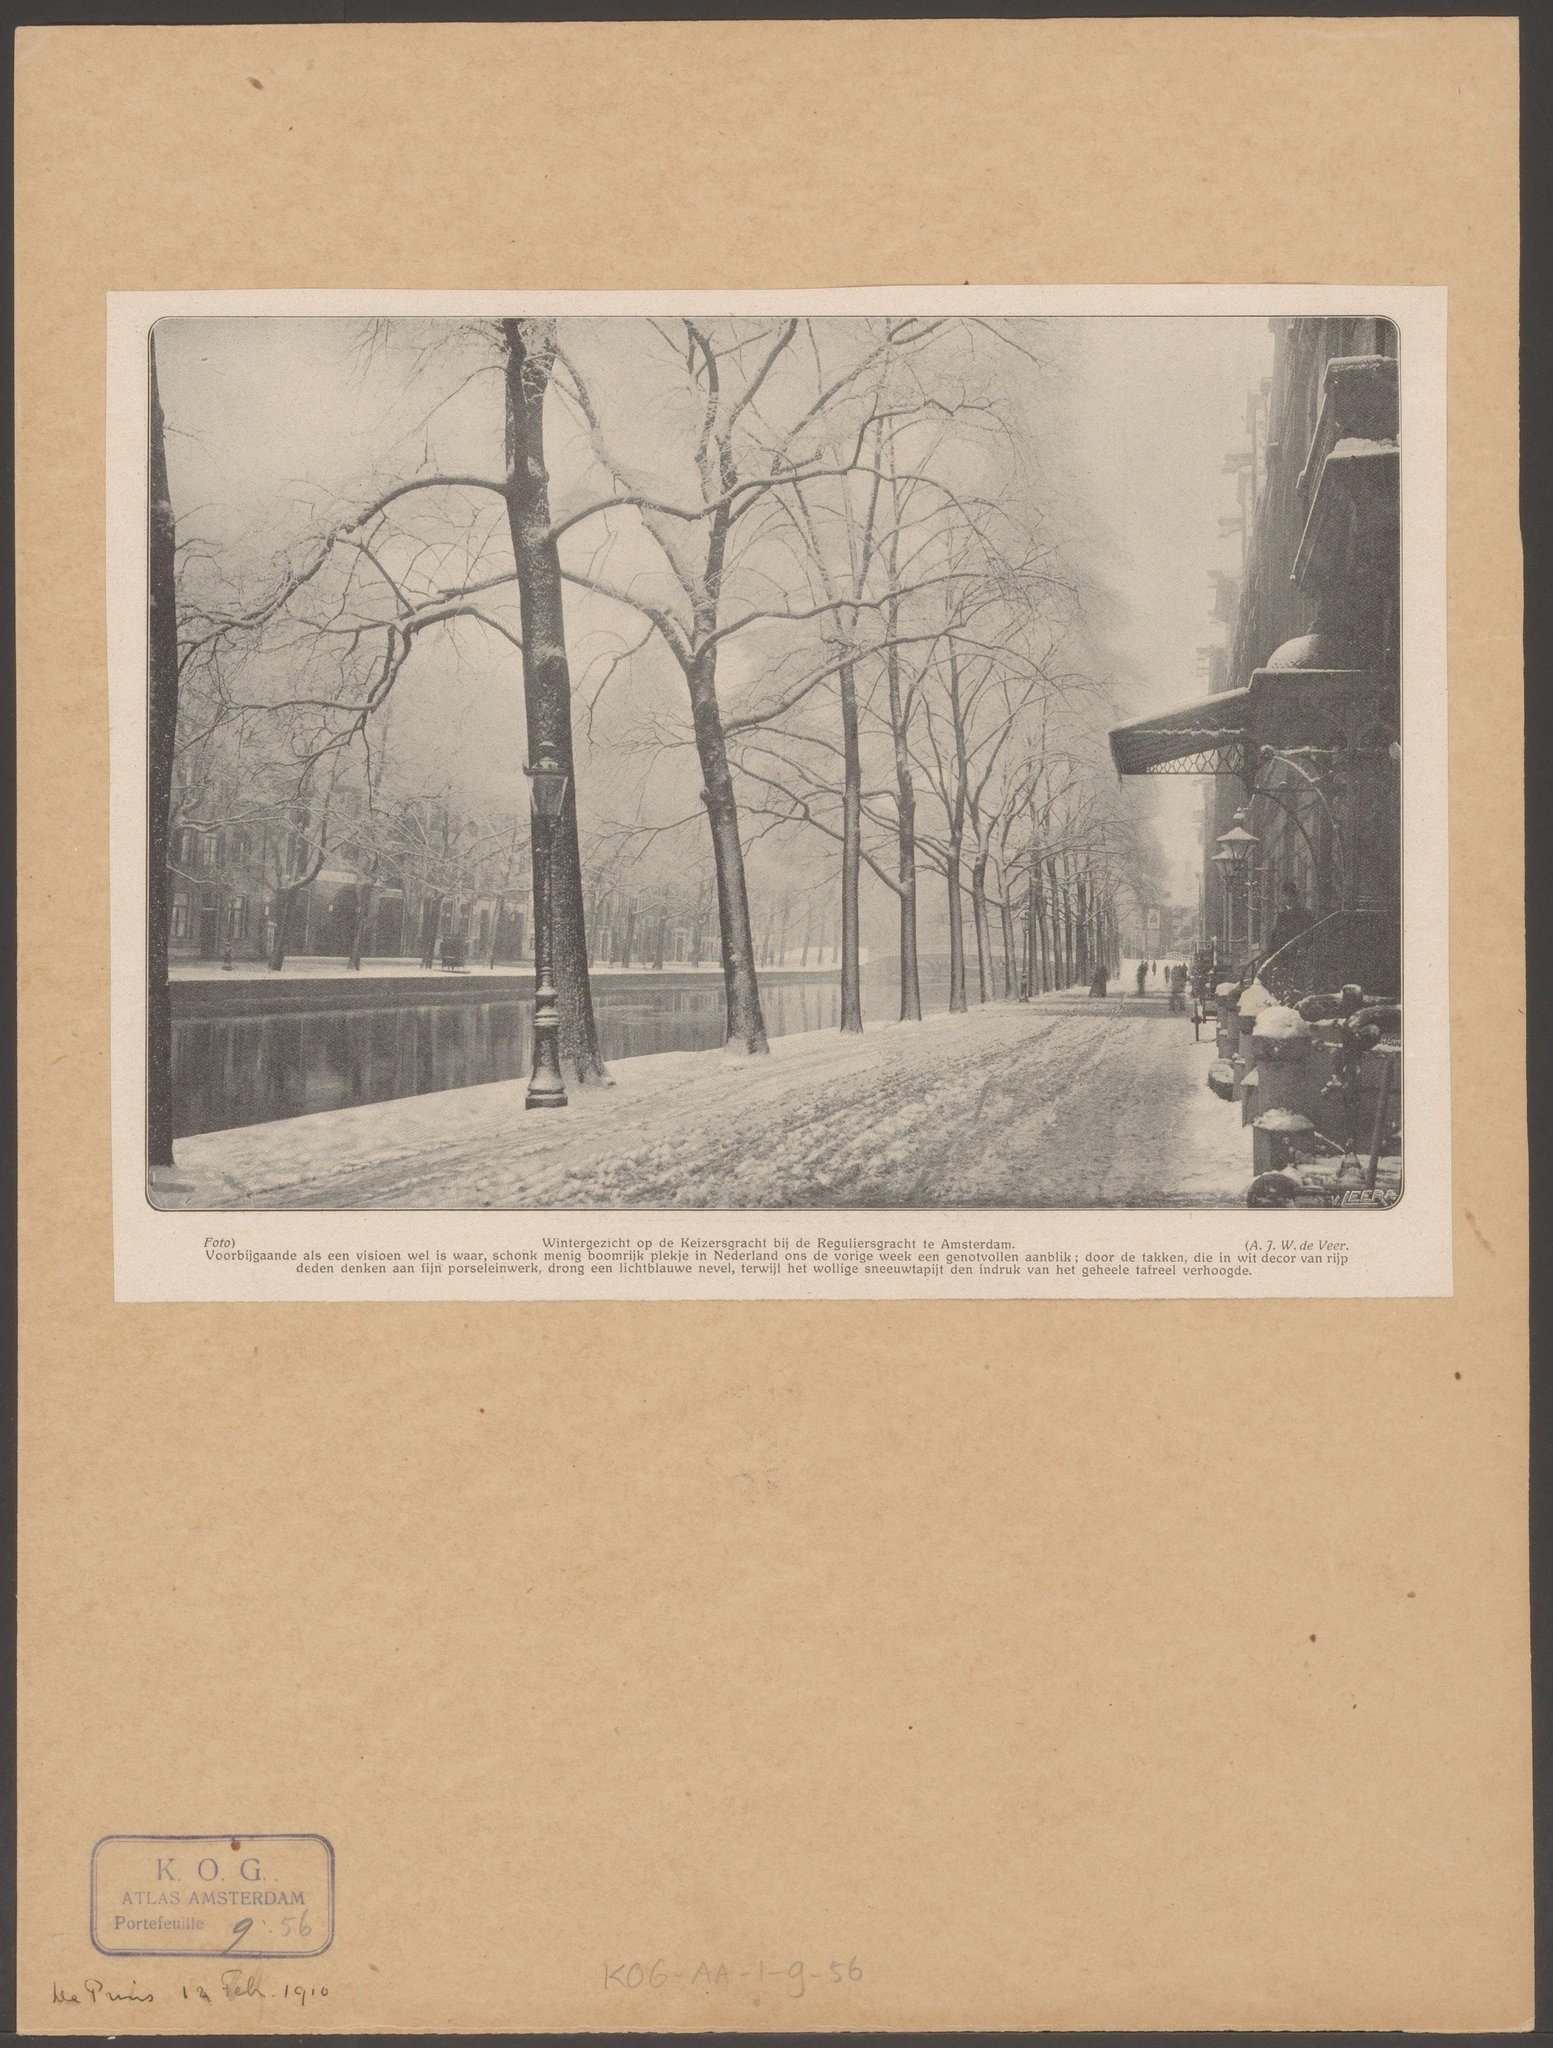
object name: photomechanical print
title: Wintergezicht op de Keizersgracht bij de Reguliersgracht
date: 1910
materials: paper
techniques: letterpress printing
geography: amsterdam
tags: city-view in general; 'veduta', canal, winter landscape; landscape symbolizing winter (the four seasons of the year), street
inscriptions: collector's mark: ‘9 56’ Lugt 1641b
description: Onderwerpsrubriek binnen de Atlas Amsterdam: Kadijksplein, Karthuizerkerkhof, Kattegat, Kattenburg, Kapelsteeg O.Z., Enge Kerksteeg, Kerkstraat, Kinkerstraat, Kolk O.Z., Koningsplein, Kromboomsloot [Krom Boomssloot], Kostverlorenkade, Kwakersdwarspad, Kalverstraat, Keizersgracht (v.d. Brouwersgracht – Amstel), Klerensloot (Gedempte), Klimopstraat, Kloveniersburgwal, Kraansluis.